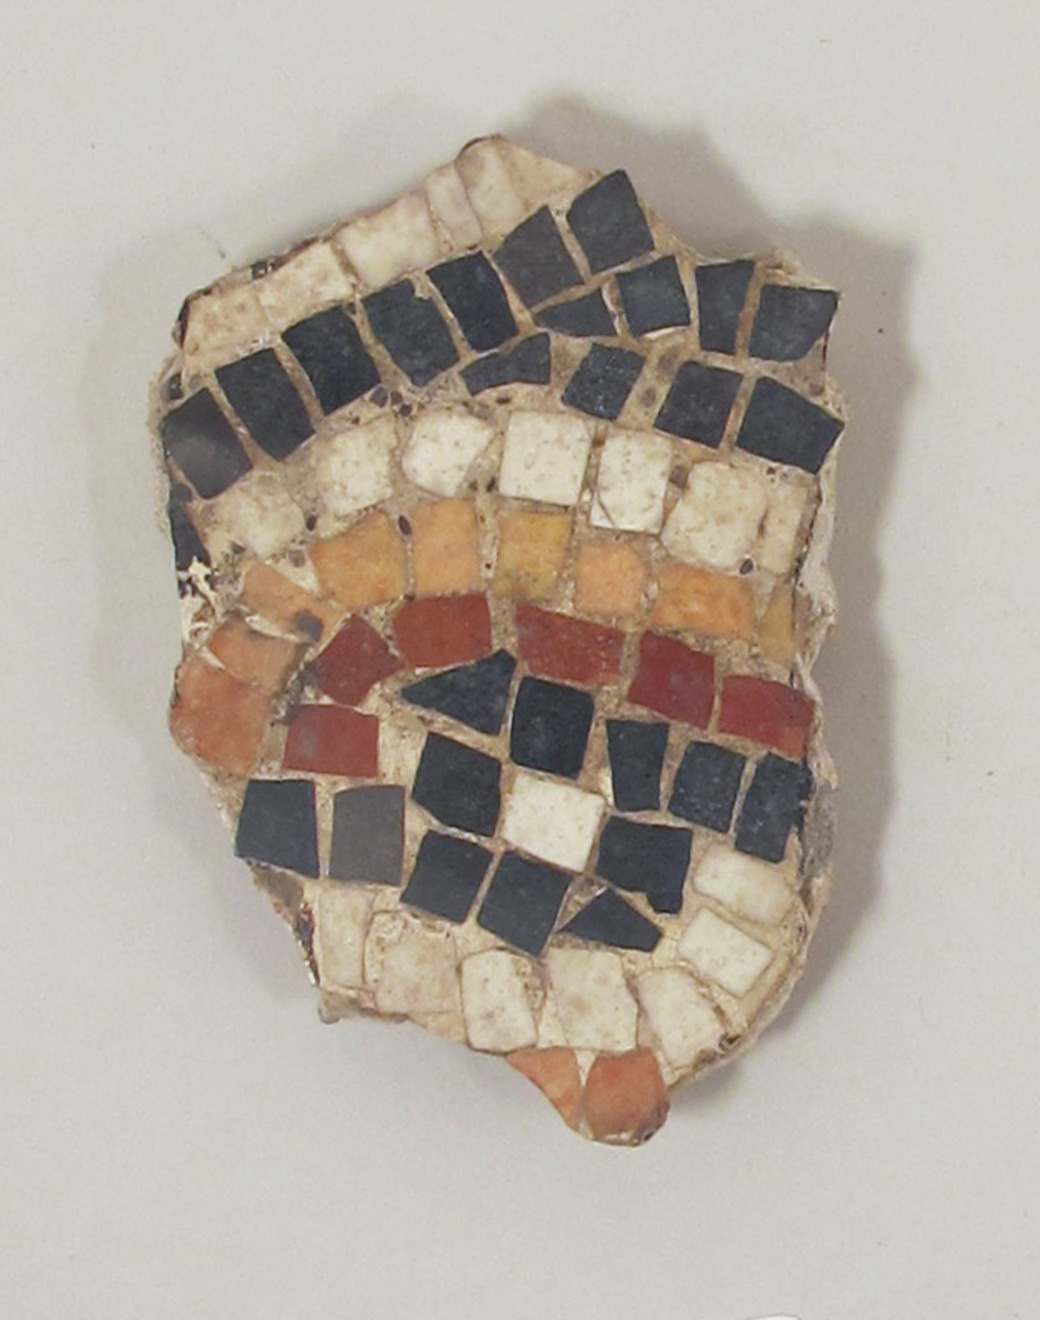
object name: mosaic pavement fragment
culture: roman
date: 670 BCE-330 CE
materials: mortar